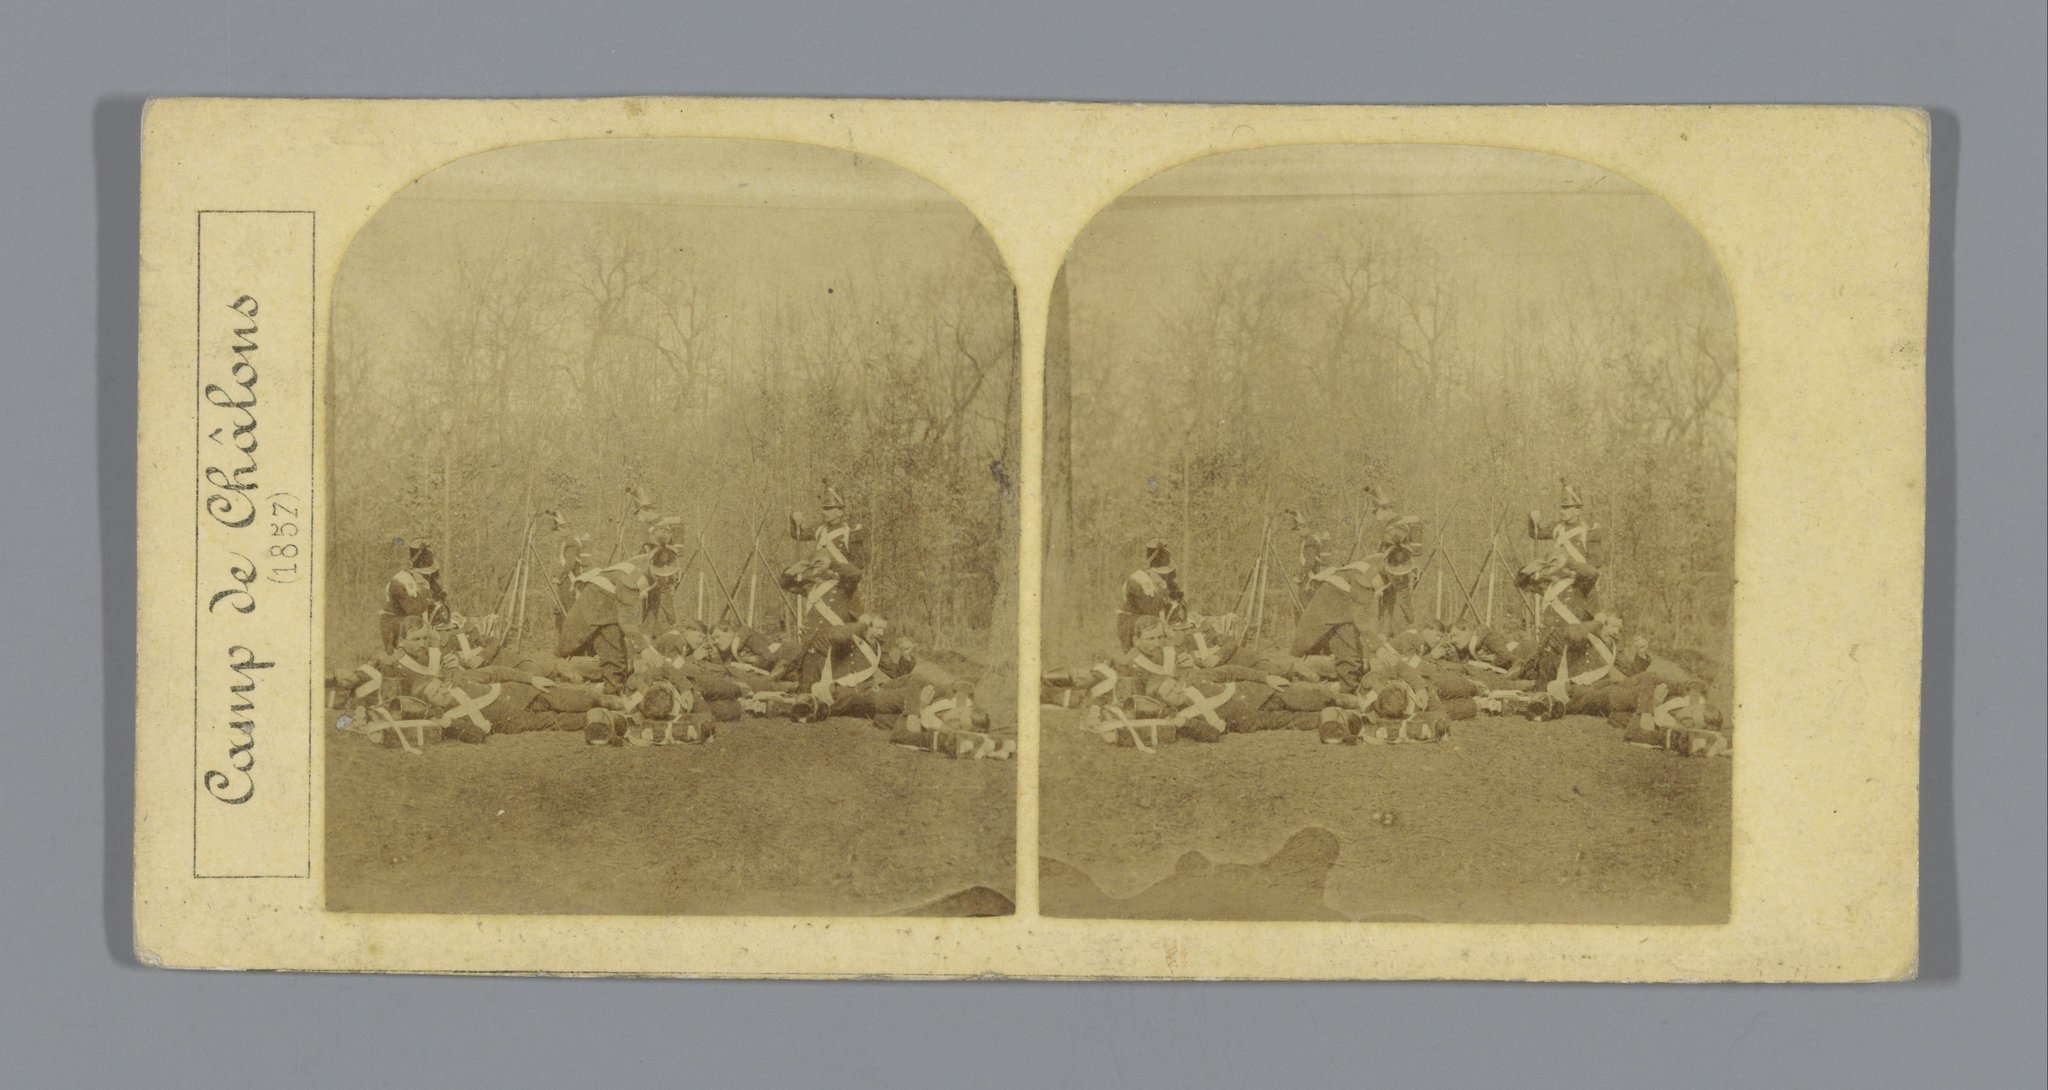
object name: stereograph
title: Korporaal wekt soldaten in het Camp de Châlons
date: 1857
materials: cardboard, photographic support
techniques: albumen print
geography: mourmelon-le-grand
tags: private soldier, reveille, the soldier; the soldier's life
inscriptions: number: ‘No. 1’, inscription: ‘Le caporal éveille les hommes qui doivent aller en faction’, number: ‘N1063’